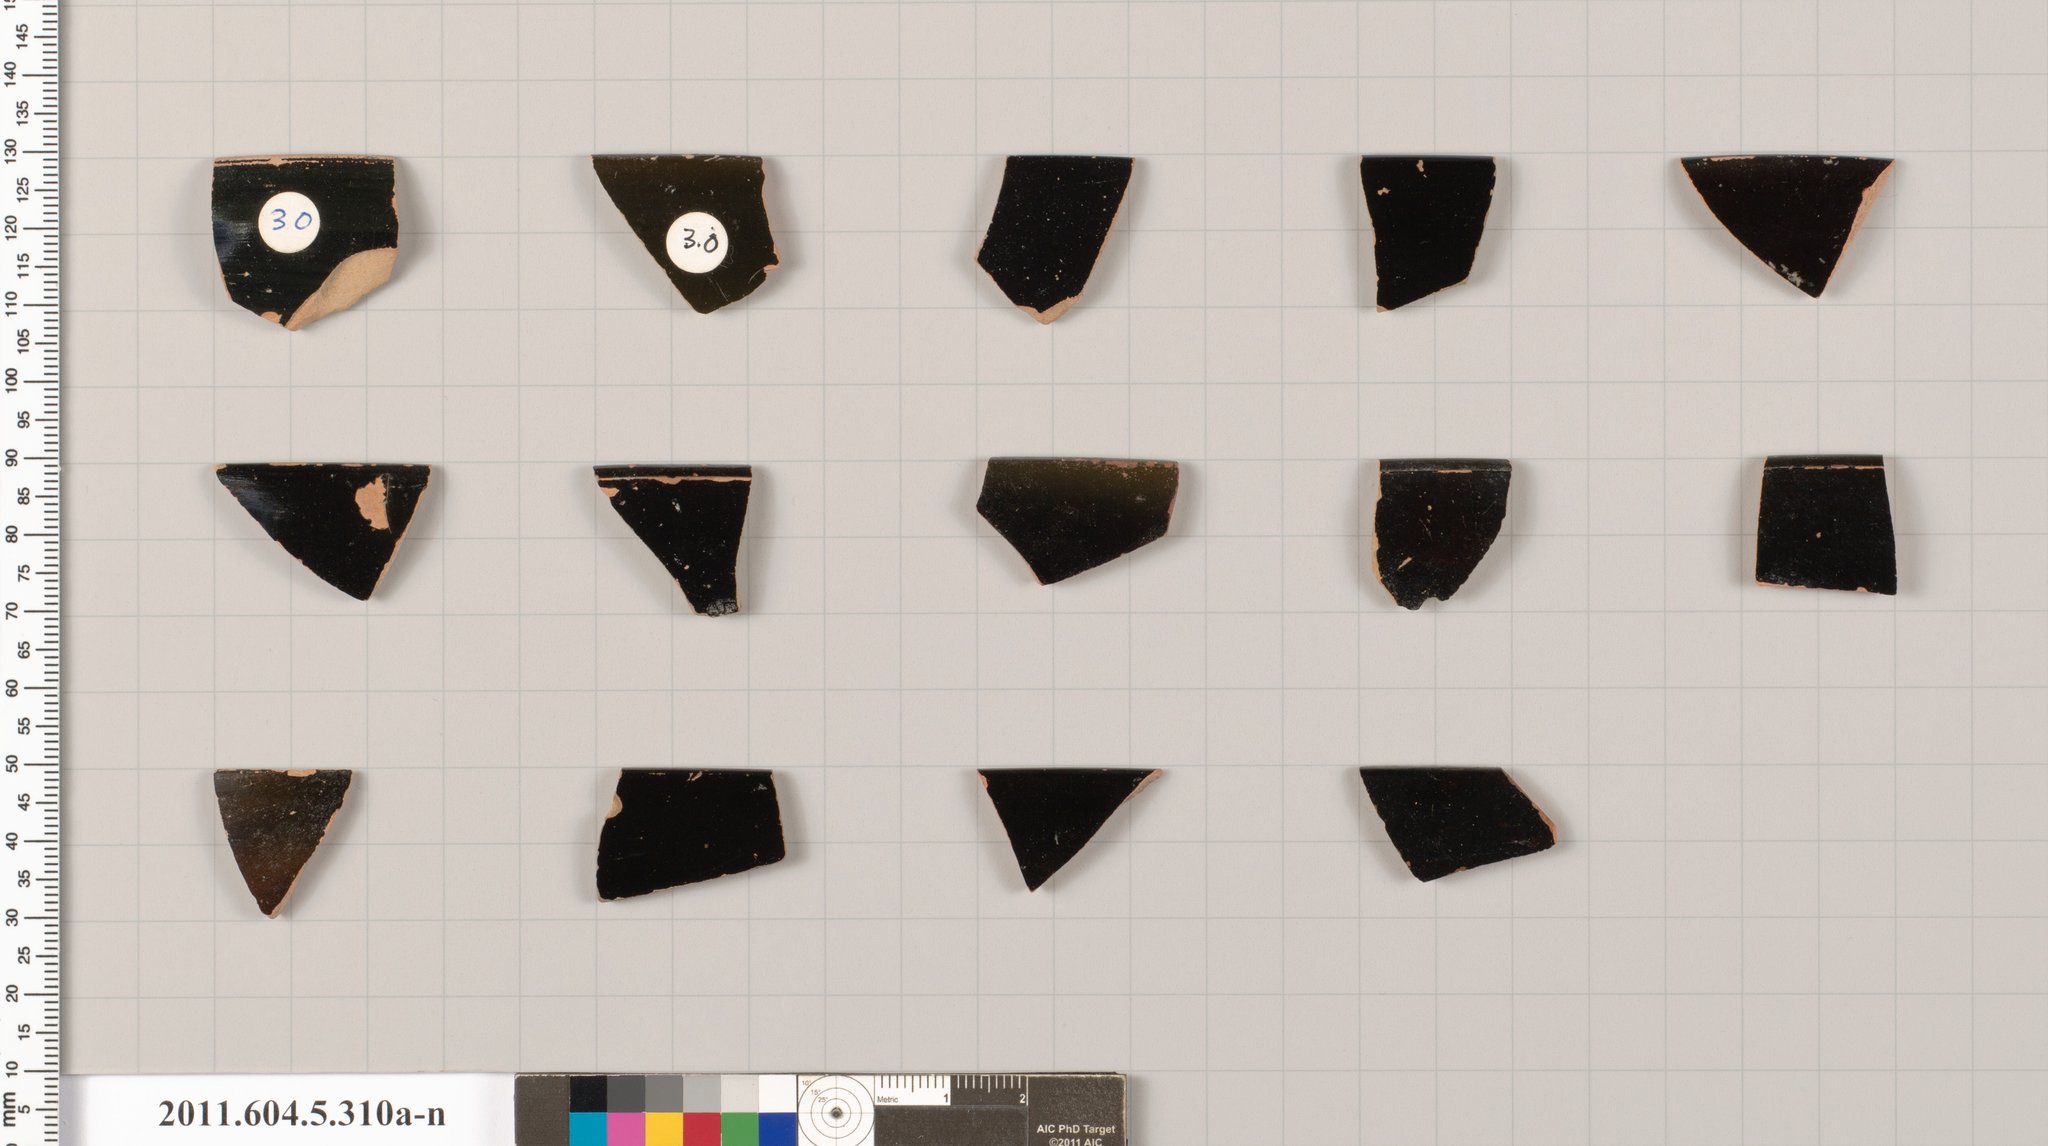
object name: kylix fragment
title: Terracotta rim fragments of kylikes (drinking cups)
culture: greek, attic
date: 600-401 BCE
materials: terracotta